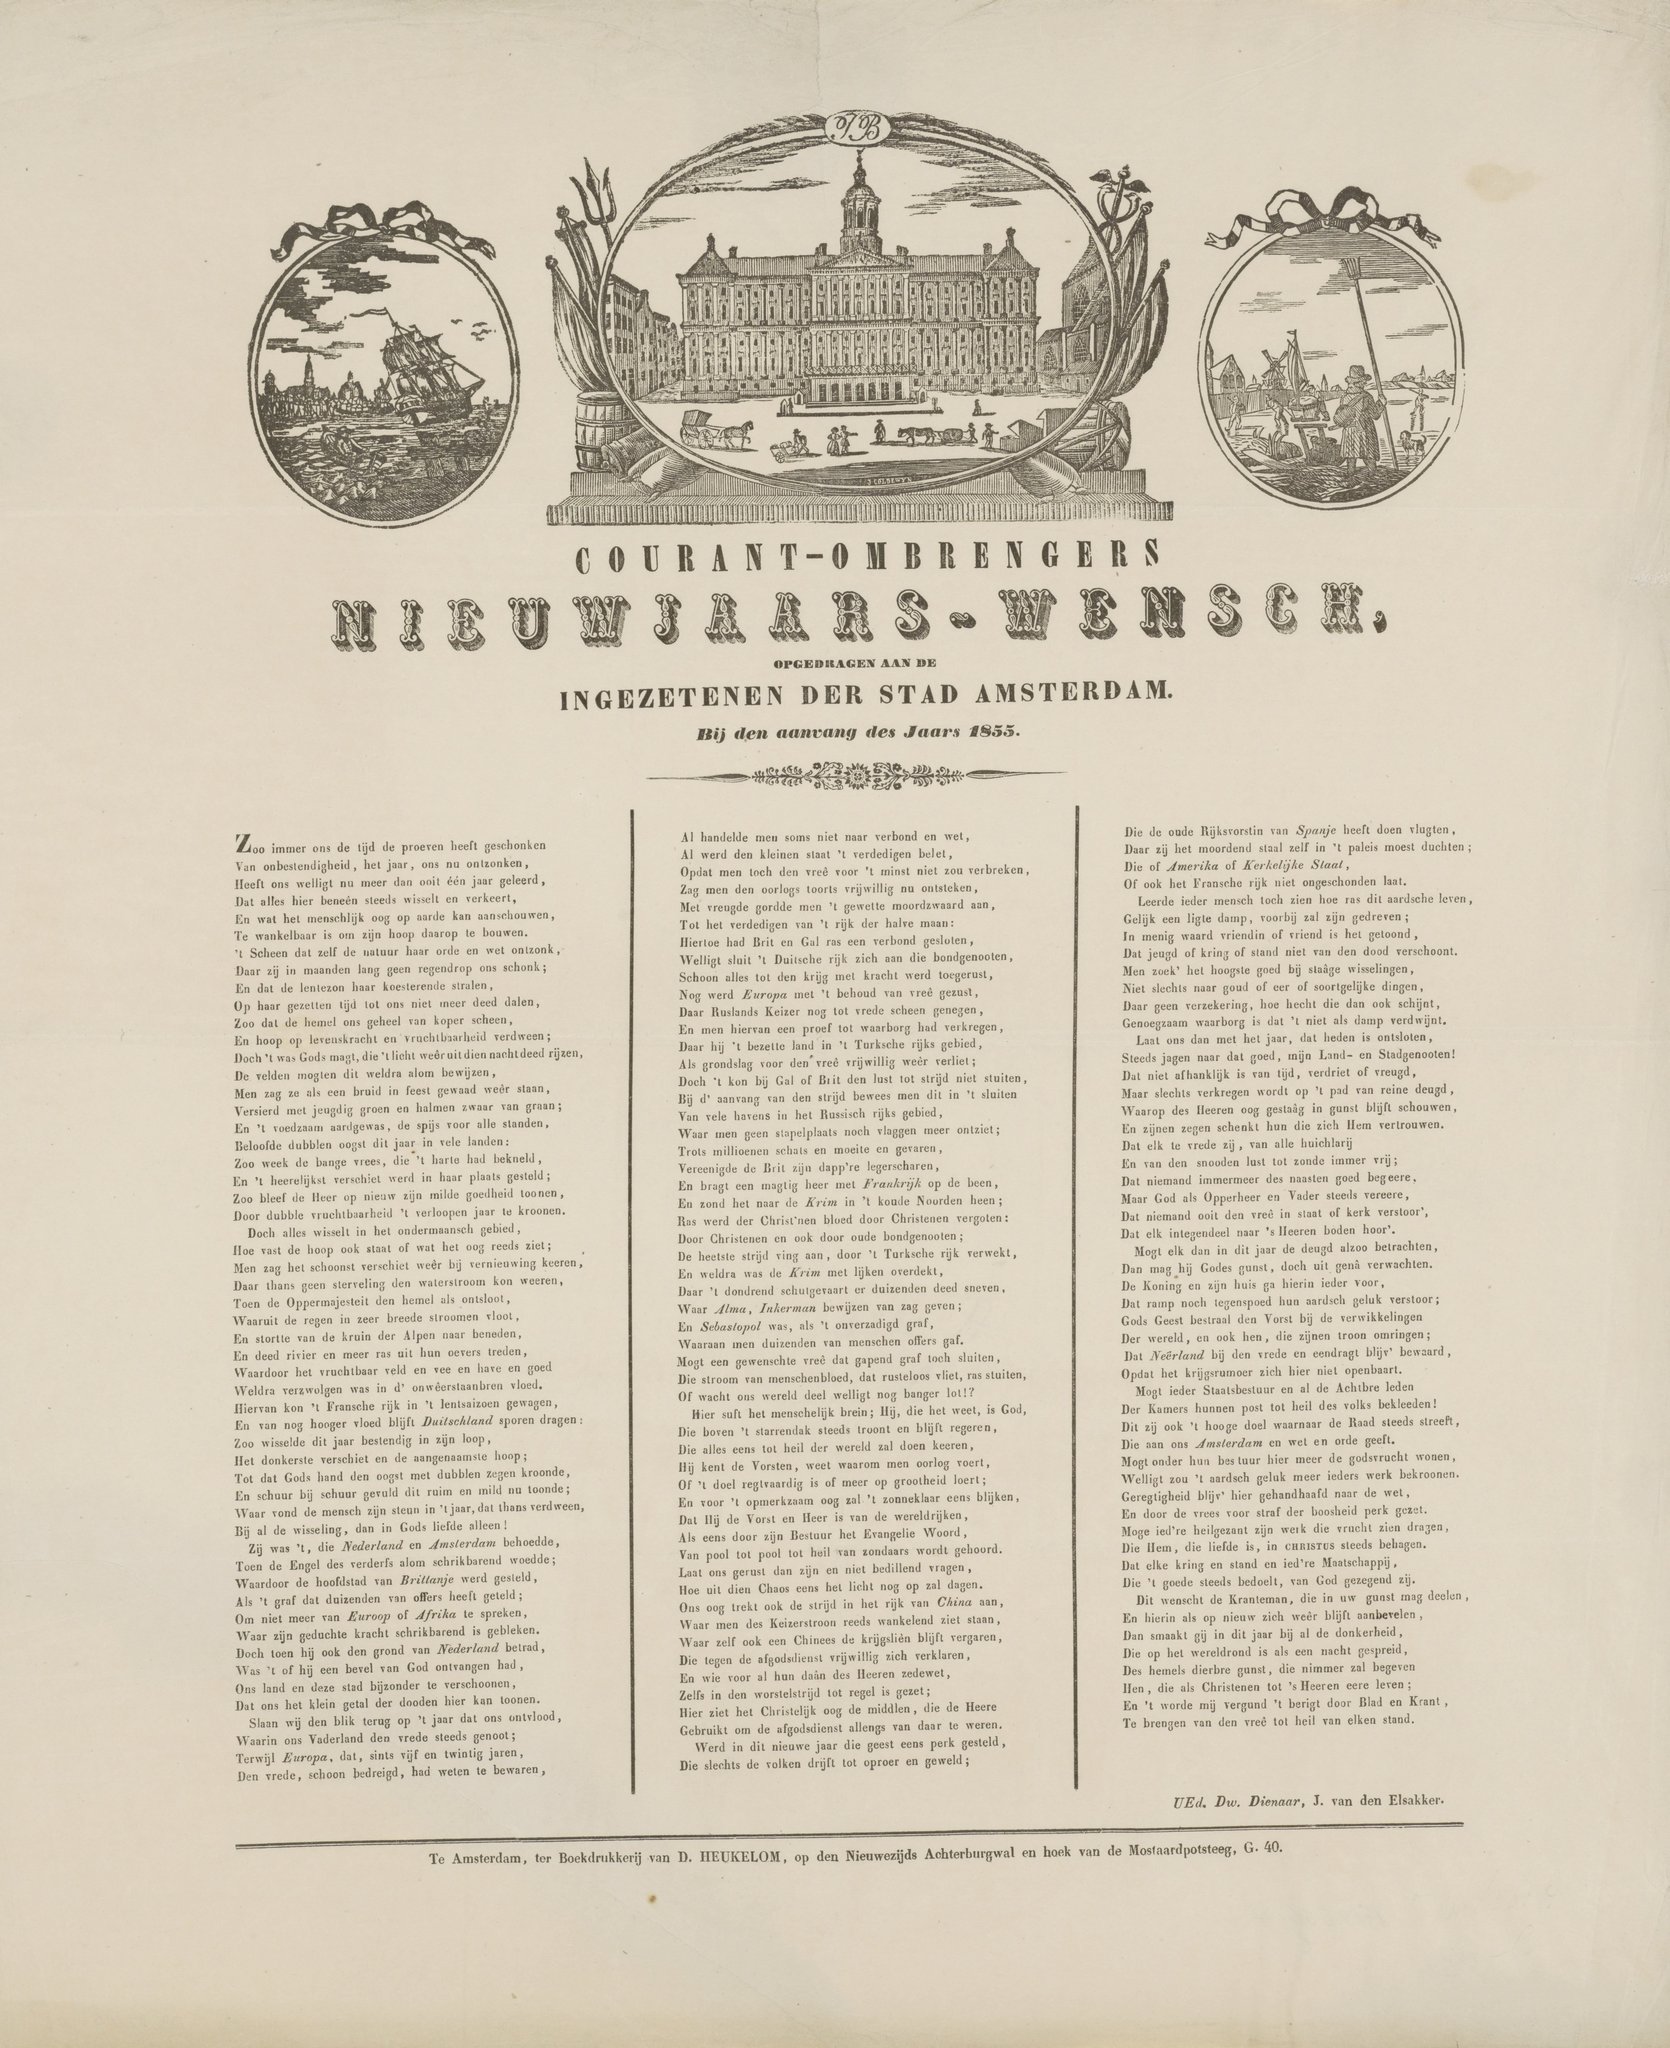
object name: print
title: Courant-ombrengers Nieuwjaars-Wensch (...) 1855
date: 1854-1855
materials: paper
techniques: letterpress printing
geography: amsterdam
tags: delivery (of newspaper), skates (winter sports), street, royal palace of amsterdam, amsterdam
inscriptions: collector's mark: Lugt 2228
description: Nieuwjaarswens namens de ombrengers van couranten (krantenbezorgers) te Amsterdam voor het jaar 1855. Bovenaan drie medaillons met centraal een gezicht op het Paleis op de Dam, links een schip op het IJ, rechts ijsvermaak buiten de stadswal. Onderaan een gedicht in drie kolommen. Van de courantombrenger: J. van den Elsakker.